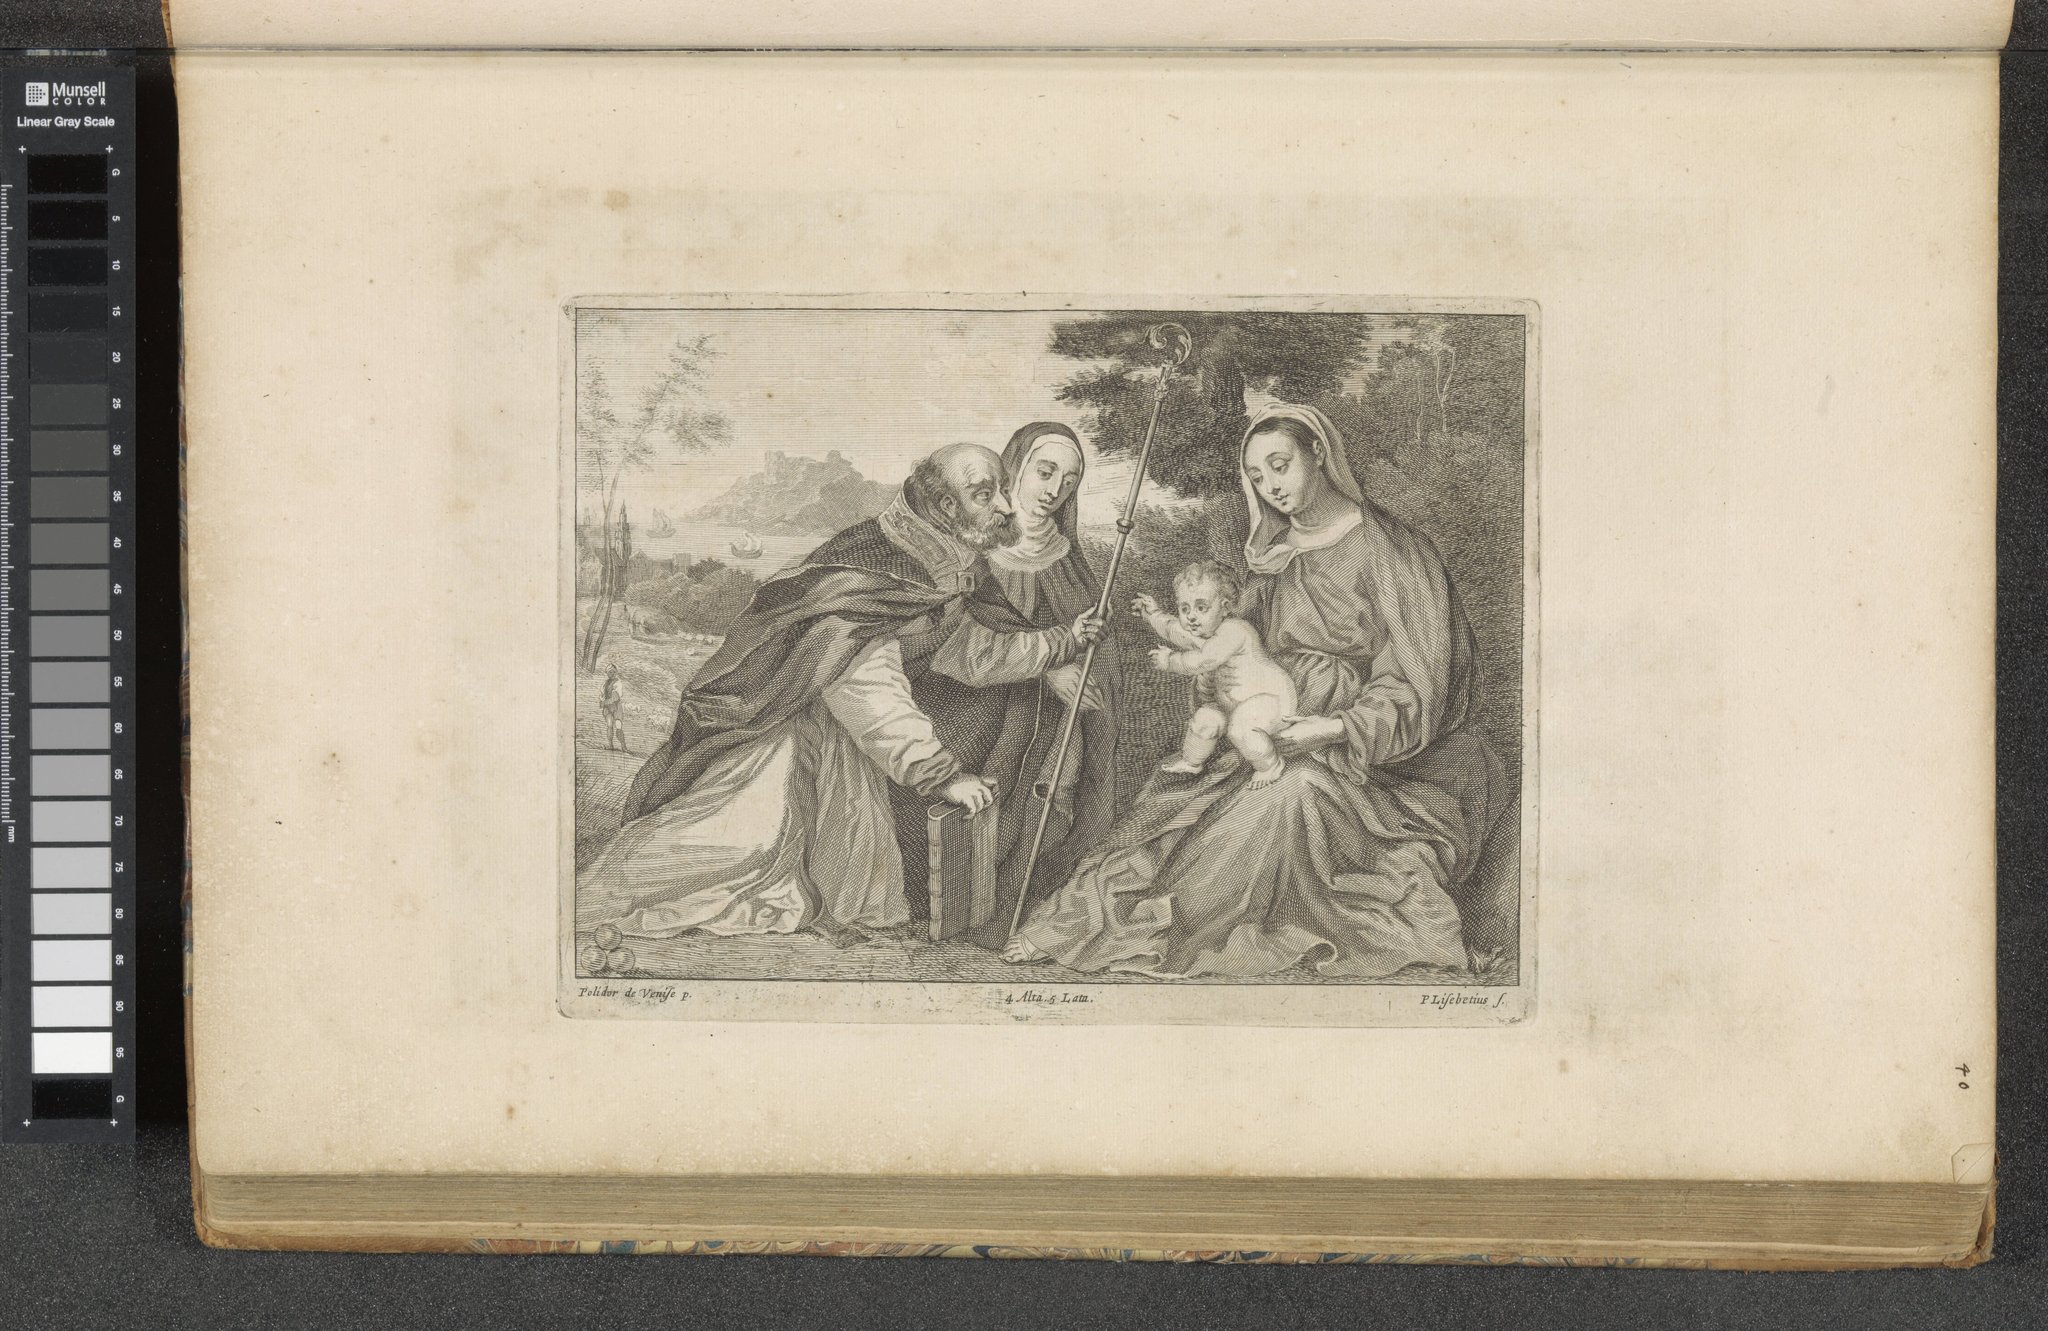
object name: print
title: H. Nicolaas van Myra knielt voor Maria en het Christuskind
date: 1660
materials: paper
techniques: engraving, etching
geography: antwerp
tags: the bishop nicholas of myra (or bari); possible attributes: anchor, boat, three golden balls (on a book), three purses, three children in a tub, three maidens, nun(s), adoration of the christ-child ~ christ's birth (+ mary), landscapes in the temperate zone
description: David Teniers heeft waarschijnlijk van alle schilderijen uit de collectie van Leopold Willem van Oostenrijk een olieverfstudie op doek of paneel vervaardigd (zgn. pasticcio), die als voorbeeld voor de prentmakers diende. Het is niet altijd duidelijk of de pasticci door hem zijn gemaakt of door zijn atelier. Niet alle pasticci zijn overgeleverd.